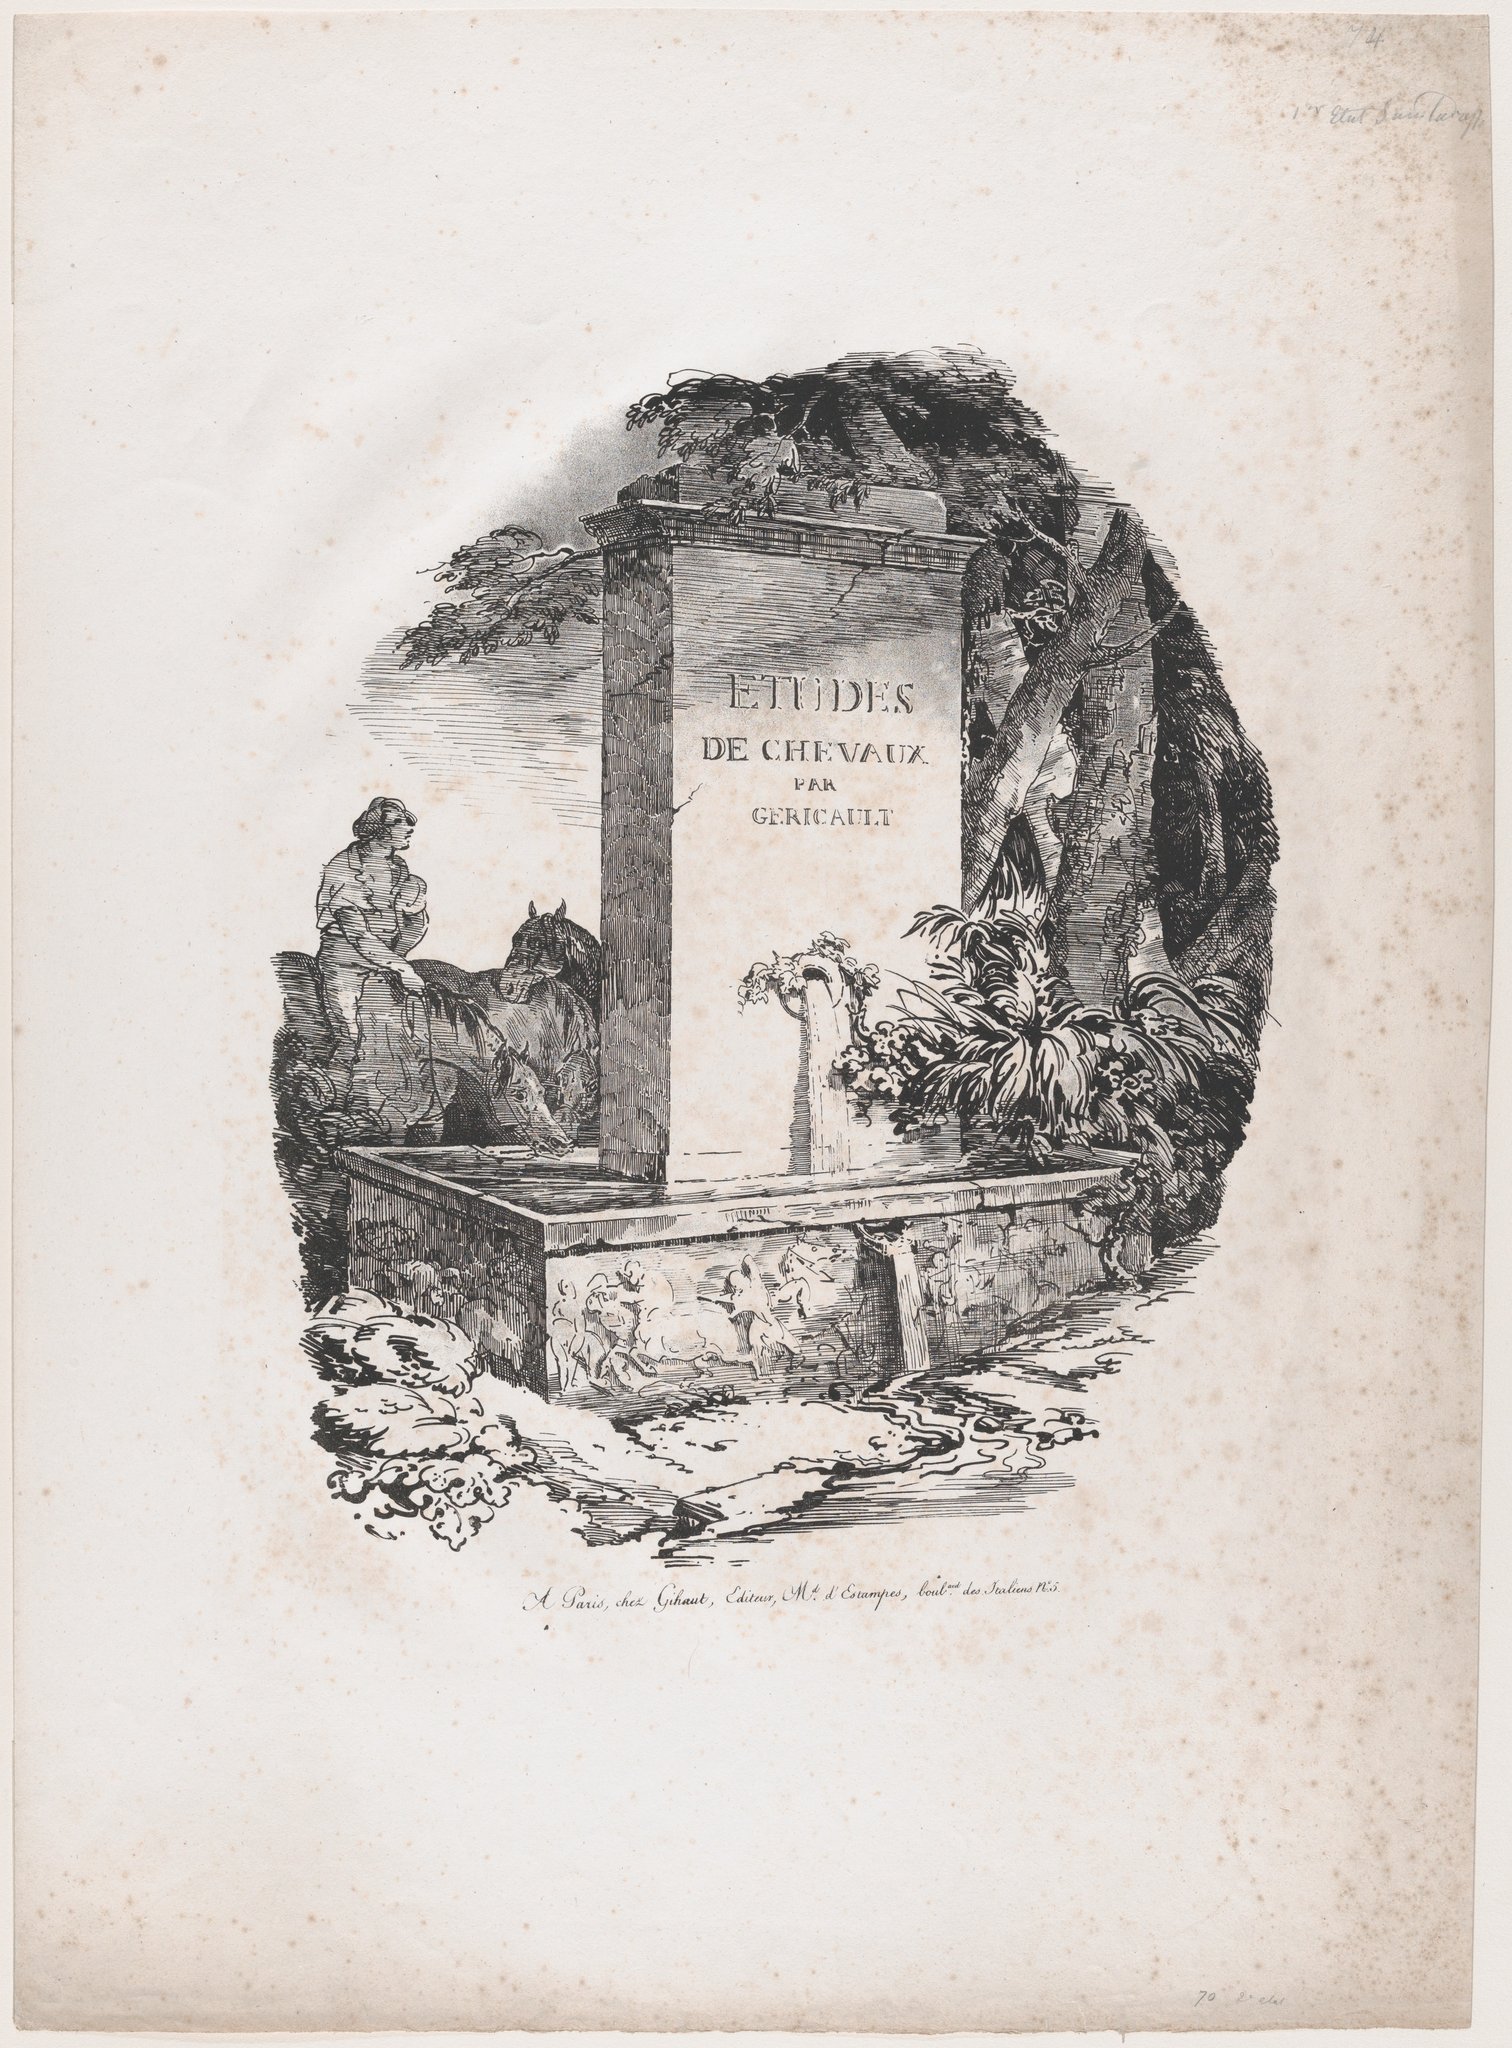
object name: print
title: Watering Trough, Title Page of "Studies of Horses" (Etudes de Chevaux)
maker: jean louis andré théodore géricault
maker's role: artist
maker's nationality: french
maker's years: 1791-1824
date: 1822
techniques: lithograph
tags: buildings,men,horses,trees